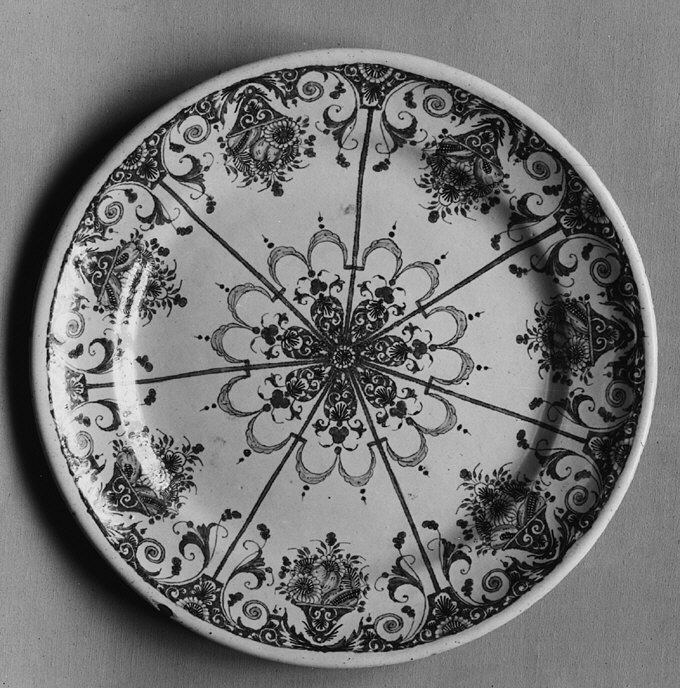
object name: plate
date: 1705-1720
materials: faience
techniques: glazing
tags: flowers